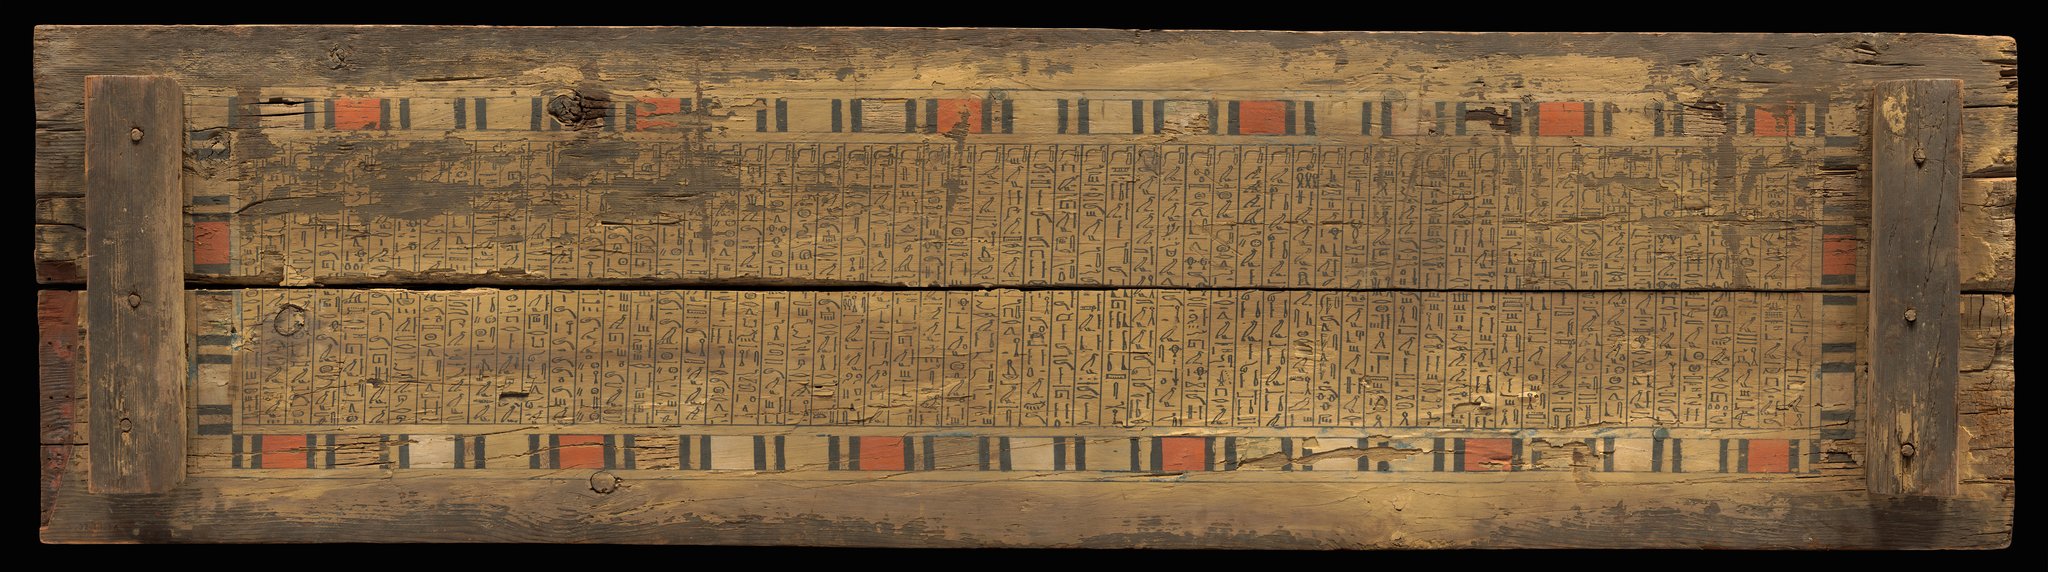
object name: coffin, khety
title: Dismantled Coffin of Khety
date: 1919-1800 BCE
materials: paint, wood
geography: egypt